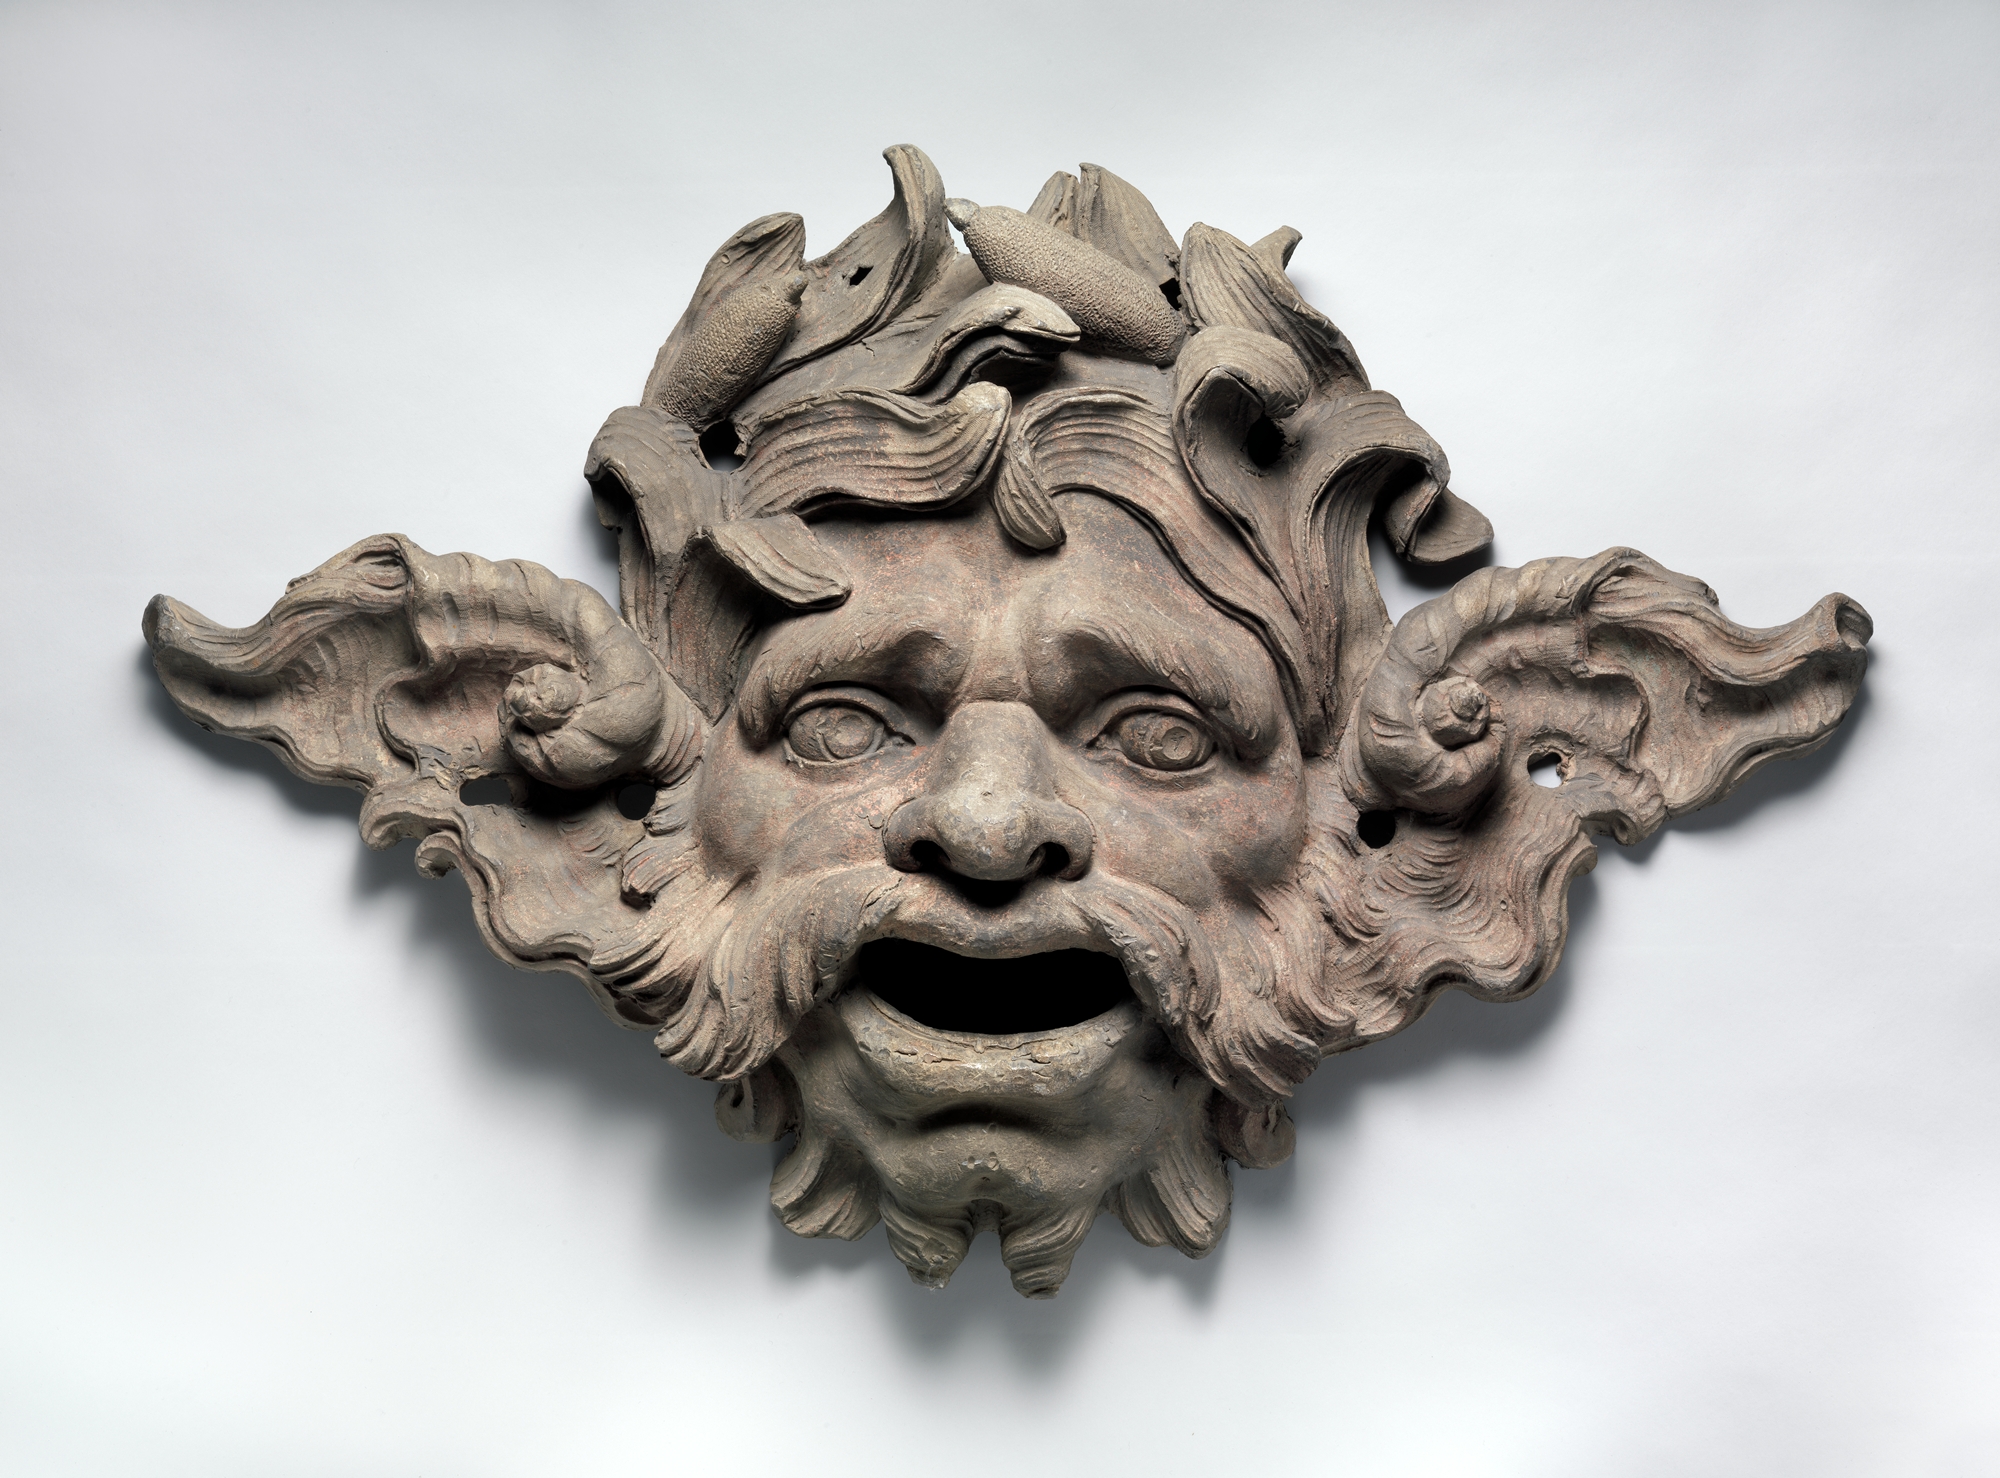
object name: mask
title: Mask (one of a pair)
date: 1701-1800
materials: lead